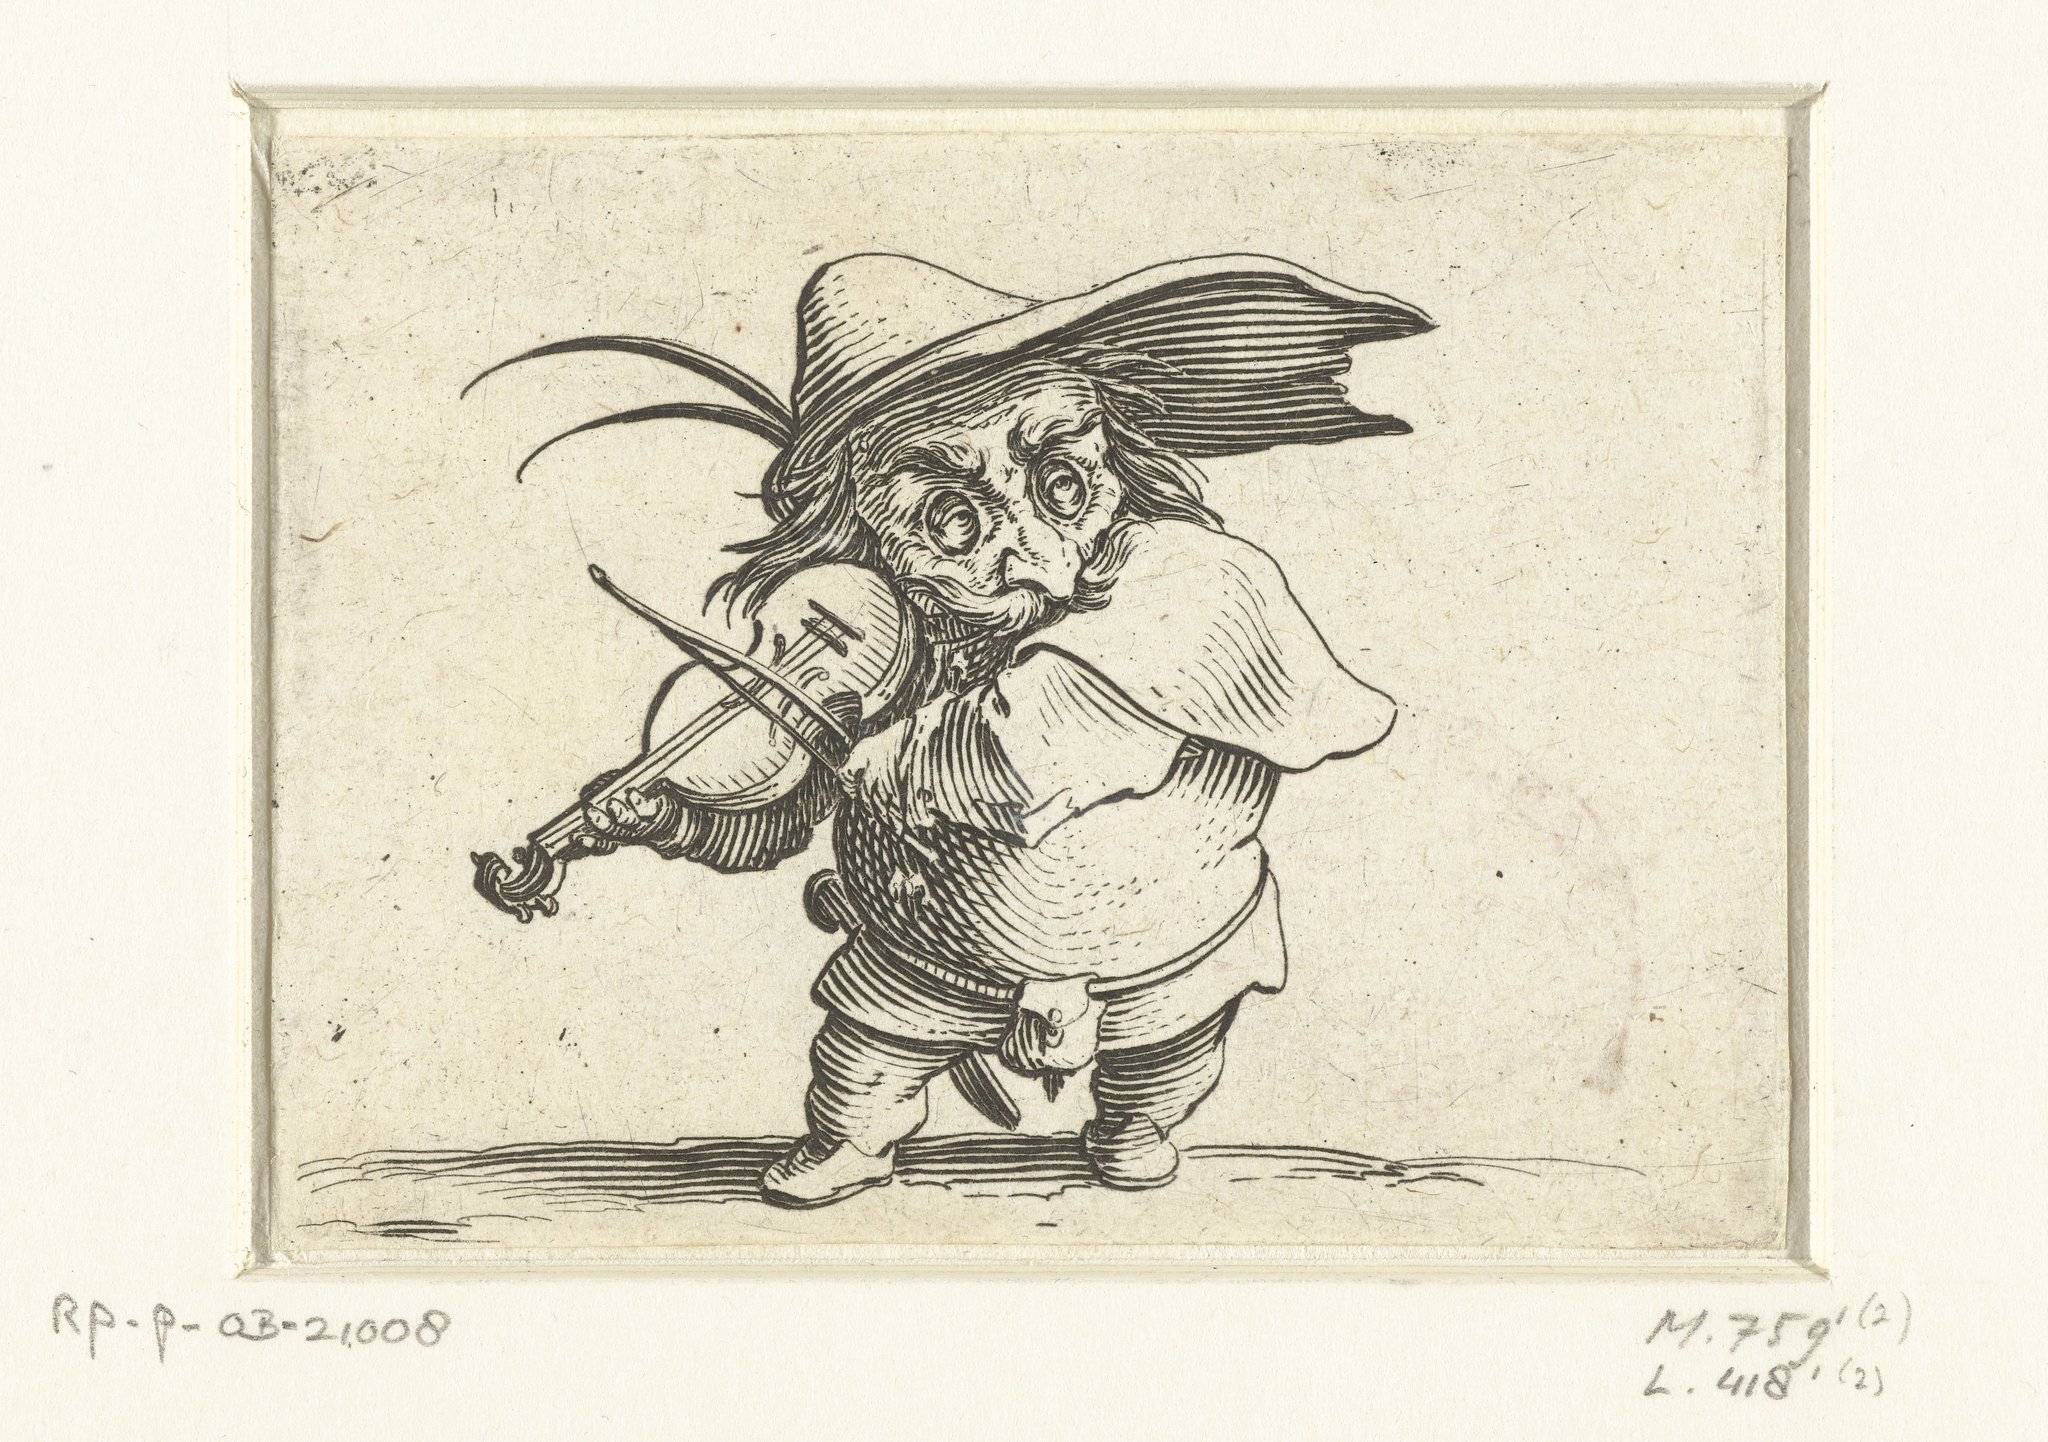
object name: print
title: Dwergen en gebochelden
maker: jacques callot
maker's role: draughtsman, print maker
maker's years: 1592-1635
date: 1621-1625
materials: paper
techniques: engraving, etching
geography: nancy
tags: one person playing string instrument (bowed), little people, violin, fiddle, hacking and thrusting weapons: sword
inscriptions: collector's mark: Lugt 240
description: Een kleine mens (karikatuur), van voren gezien, een viool bespelend, een hoed met twee veren op het hoofd, een zwaard aan zijn rechterzijde. Deze prent is onderdeel van een serie van 21 prenten met groteske figuren; vrijwel al die figuren zijn karikaturen van kleine mensen, velen zijn gebocheld.